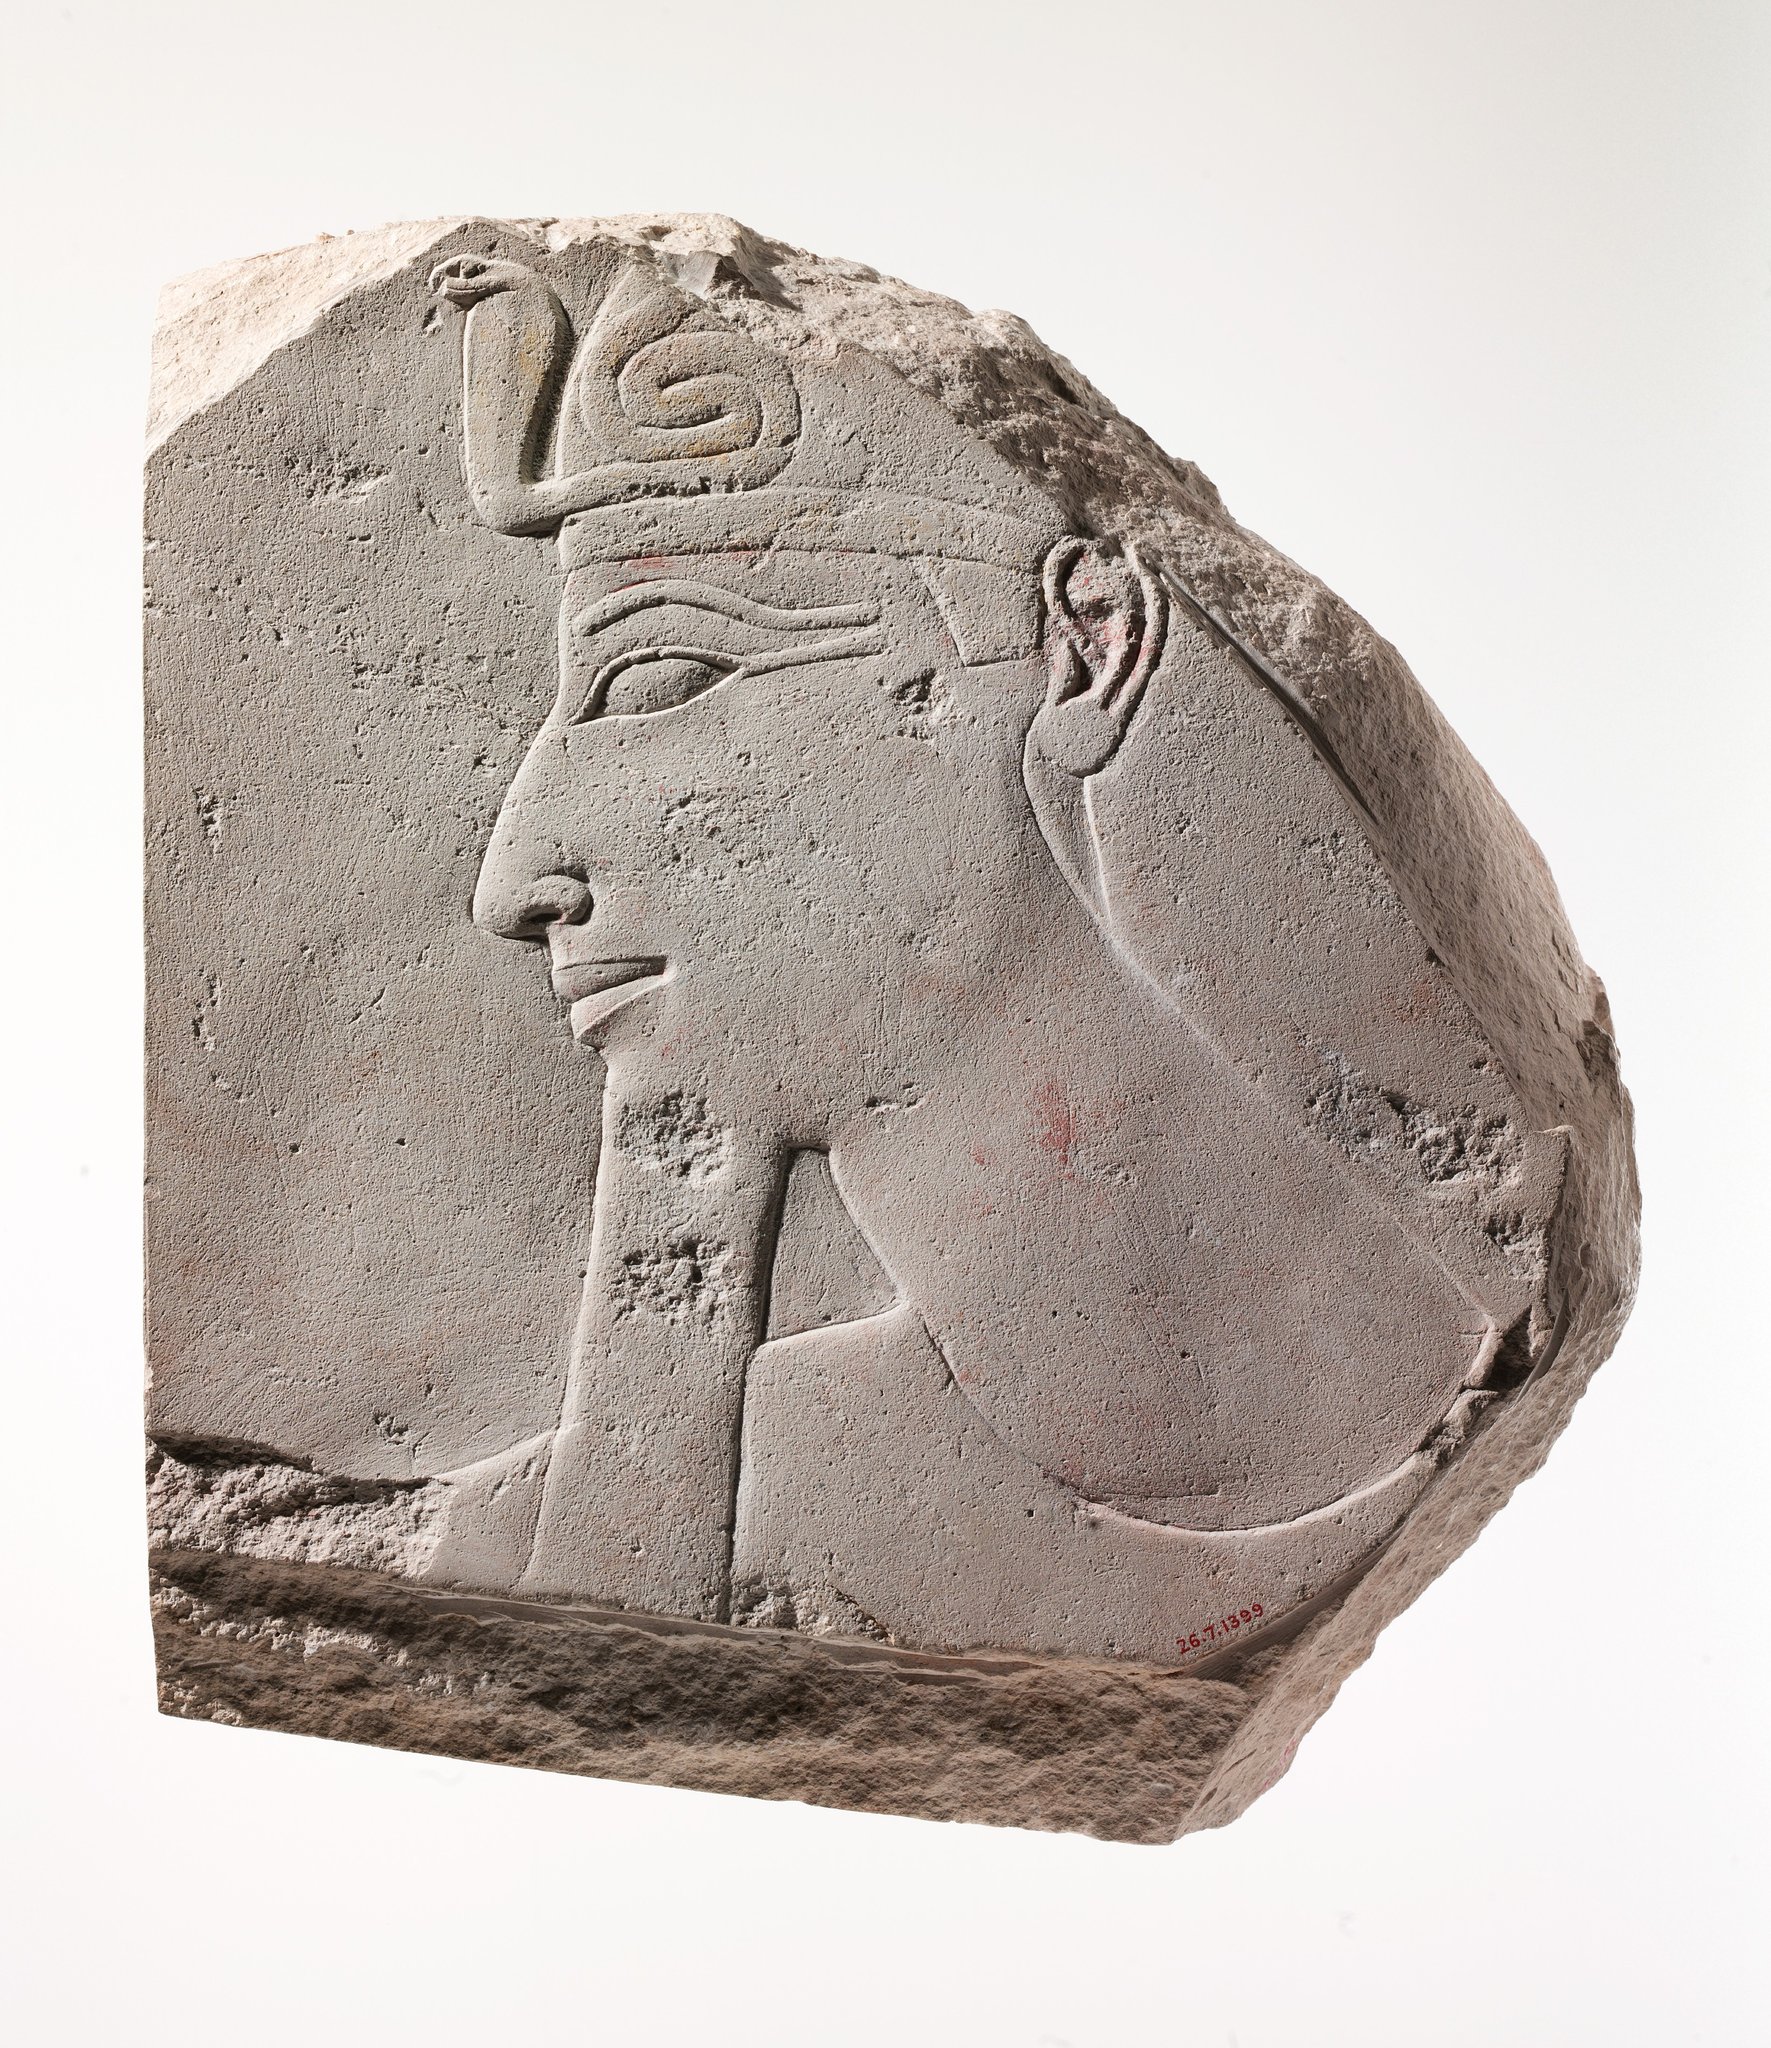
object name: relief, royal head, thutmose iii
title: Relief of Thutmose III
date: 1458-1425 BCE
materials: limestone, paint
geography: egypt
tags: men